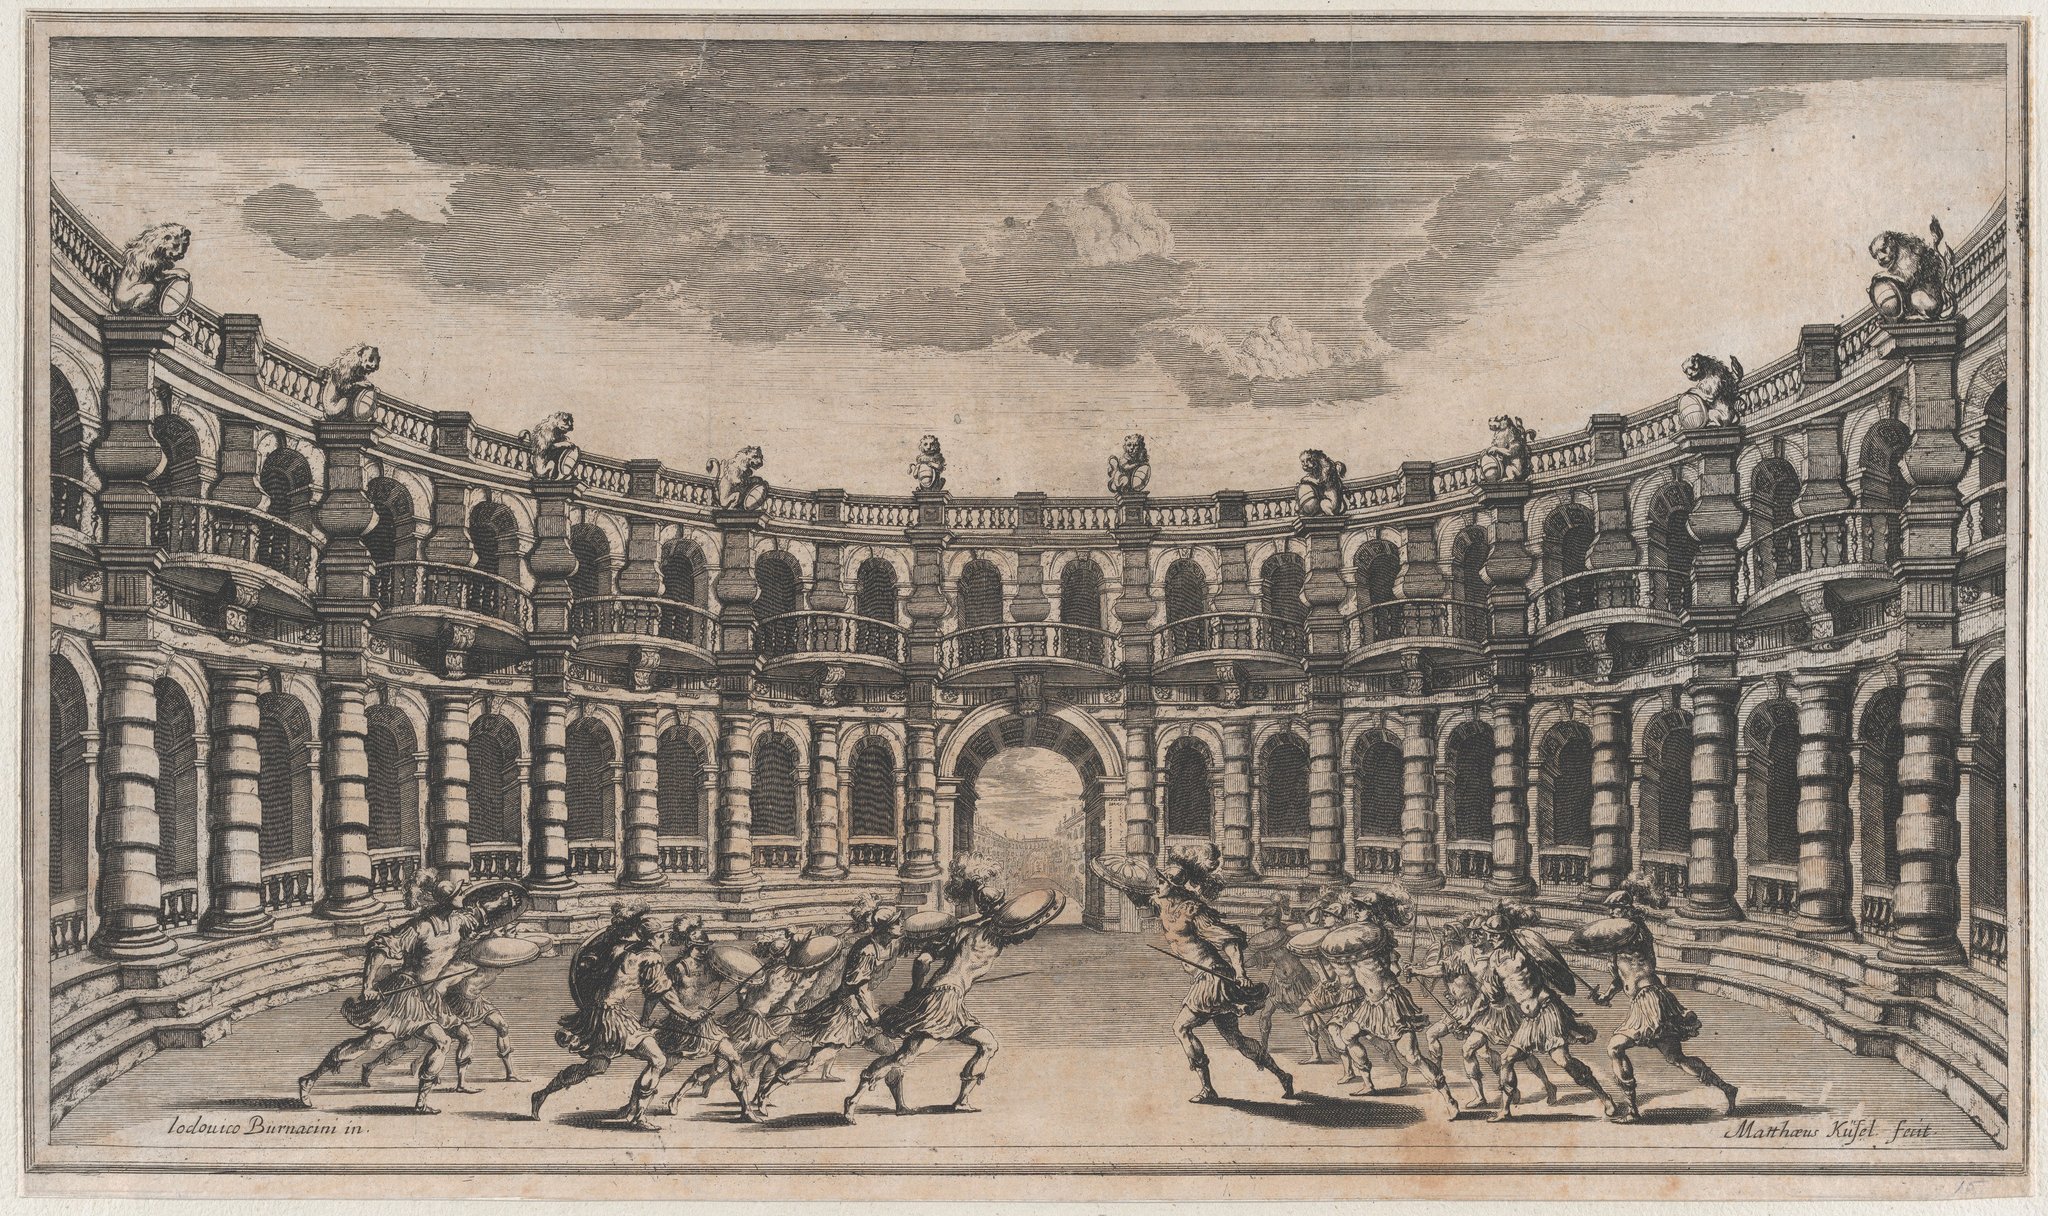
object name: print, fete, ornament architecture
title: Amphitheater with two groups of soldiers running toward each other; set design from 'Il Pomo D'Oro'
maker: mathäus küsel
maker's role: artist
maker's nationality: german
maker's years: 1621-1682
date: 1668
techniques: etching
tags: amphitheatres,soldiers,running